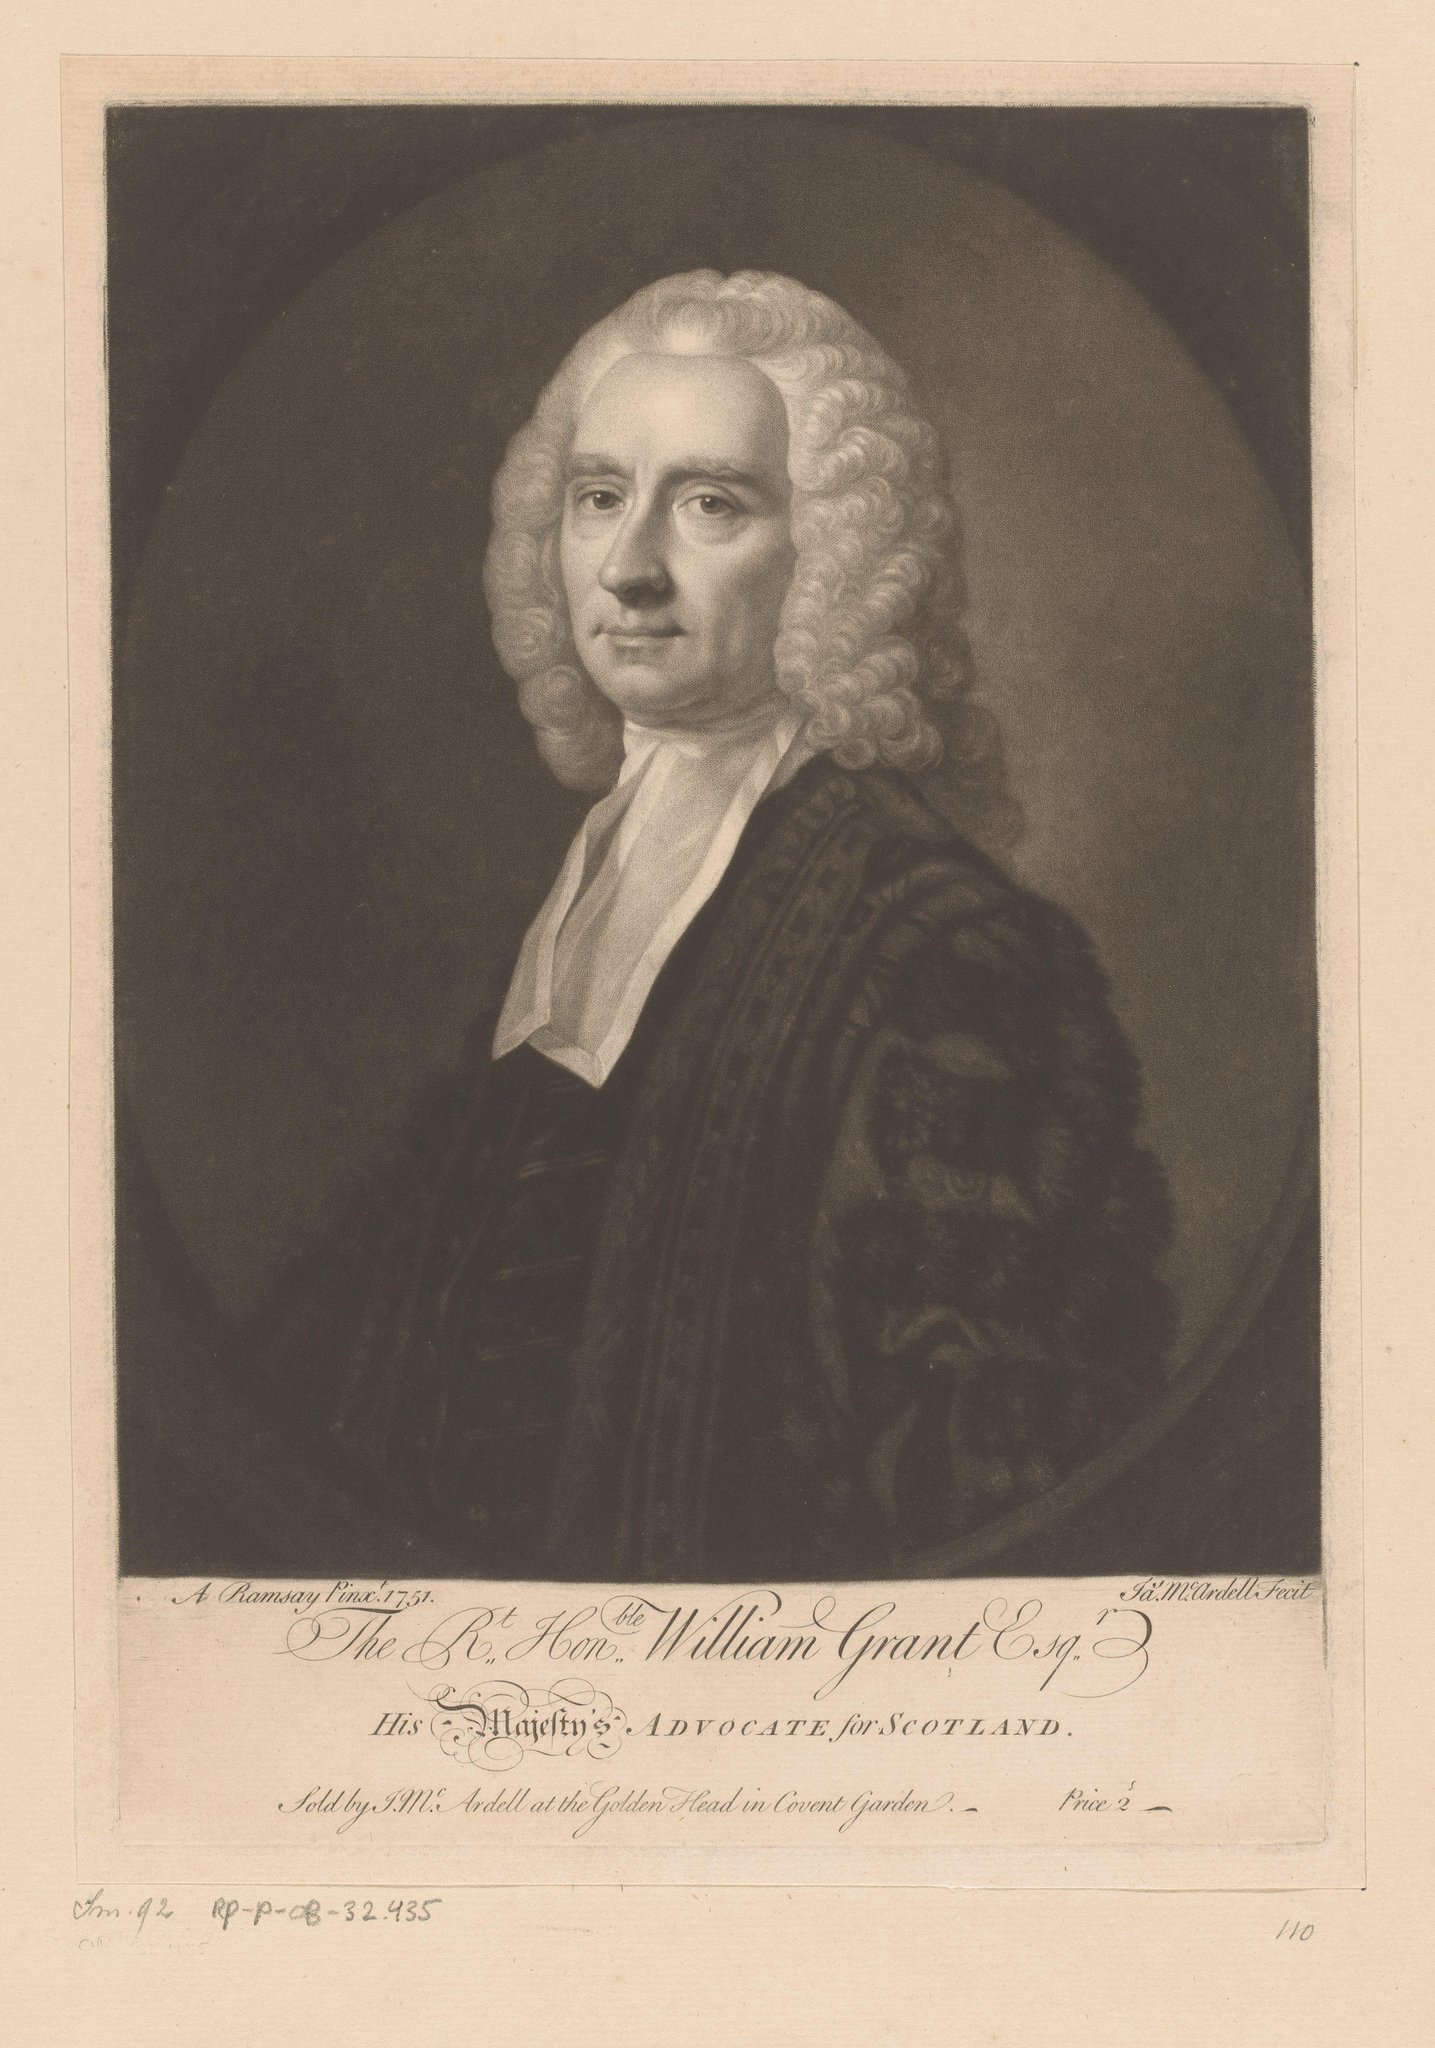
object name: print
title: Portret van William Grant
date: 1751-1753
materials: paper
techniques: mezzotint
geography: london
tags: historical persons, politician, e.g. party leader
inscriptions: collector's mark: Lugt 240